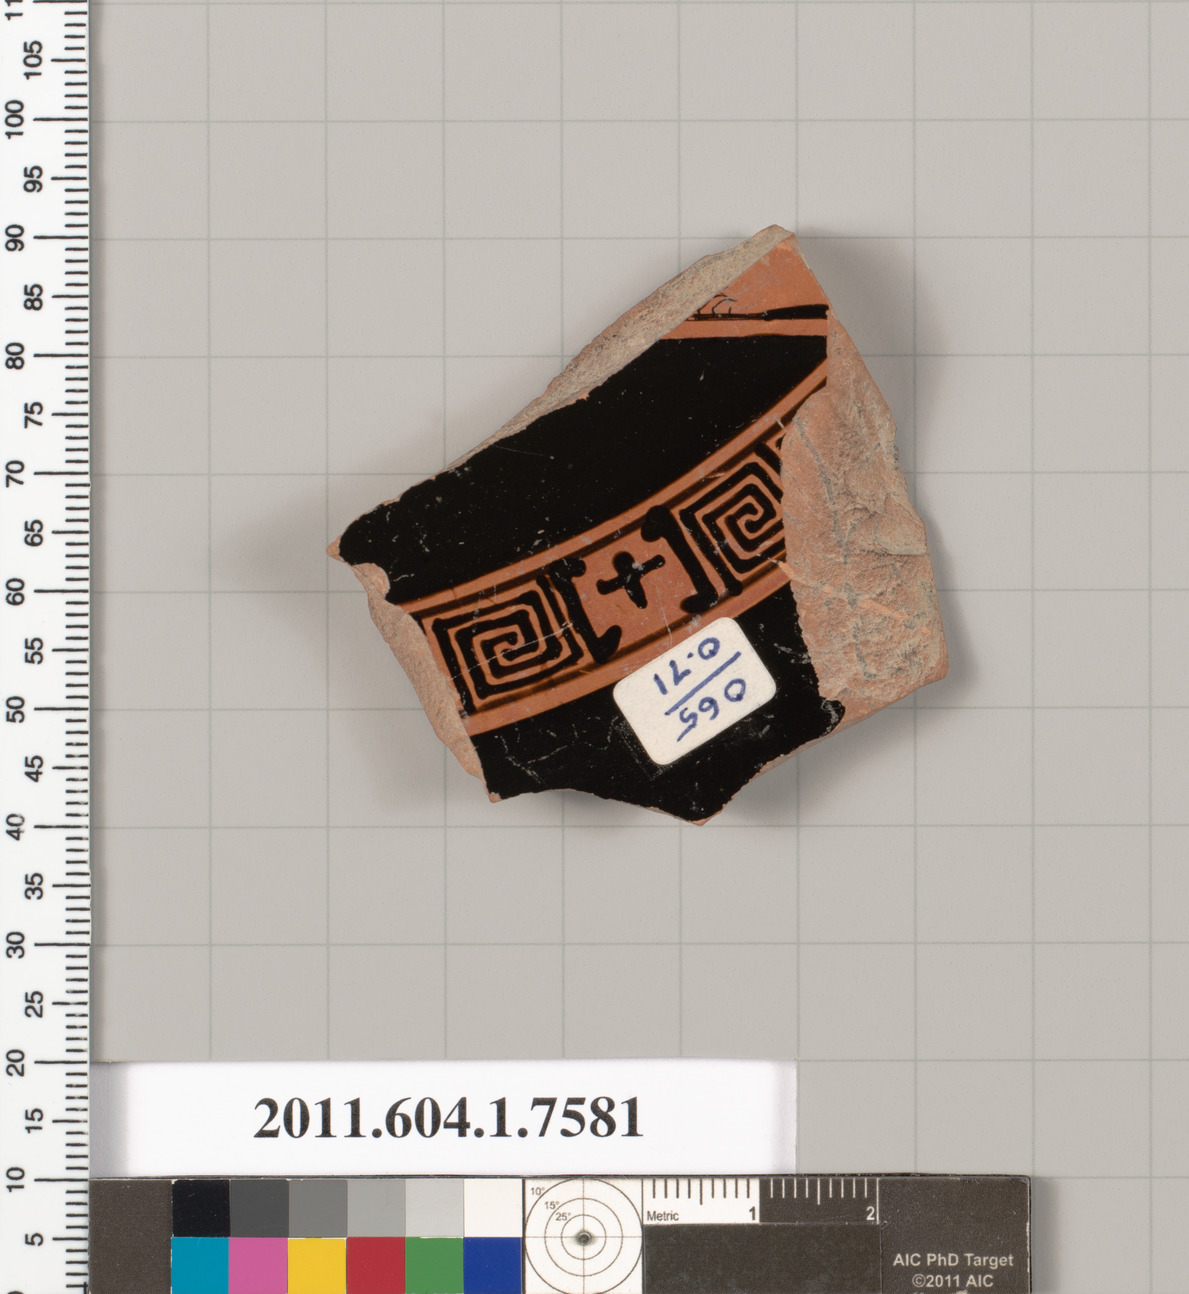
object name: kylix fragment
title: Terracotta fragment of a kylix (drinking cup)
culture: greek, attic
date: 460-450 BCE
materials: terracotta